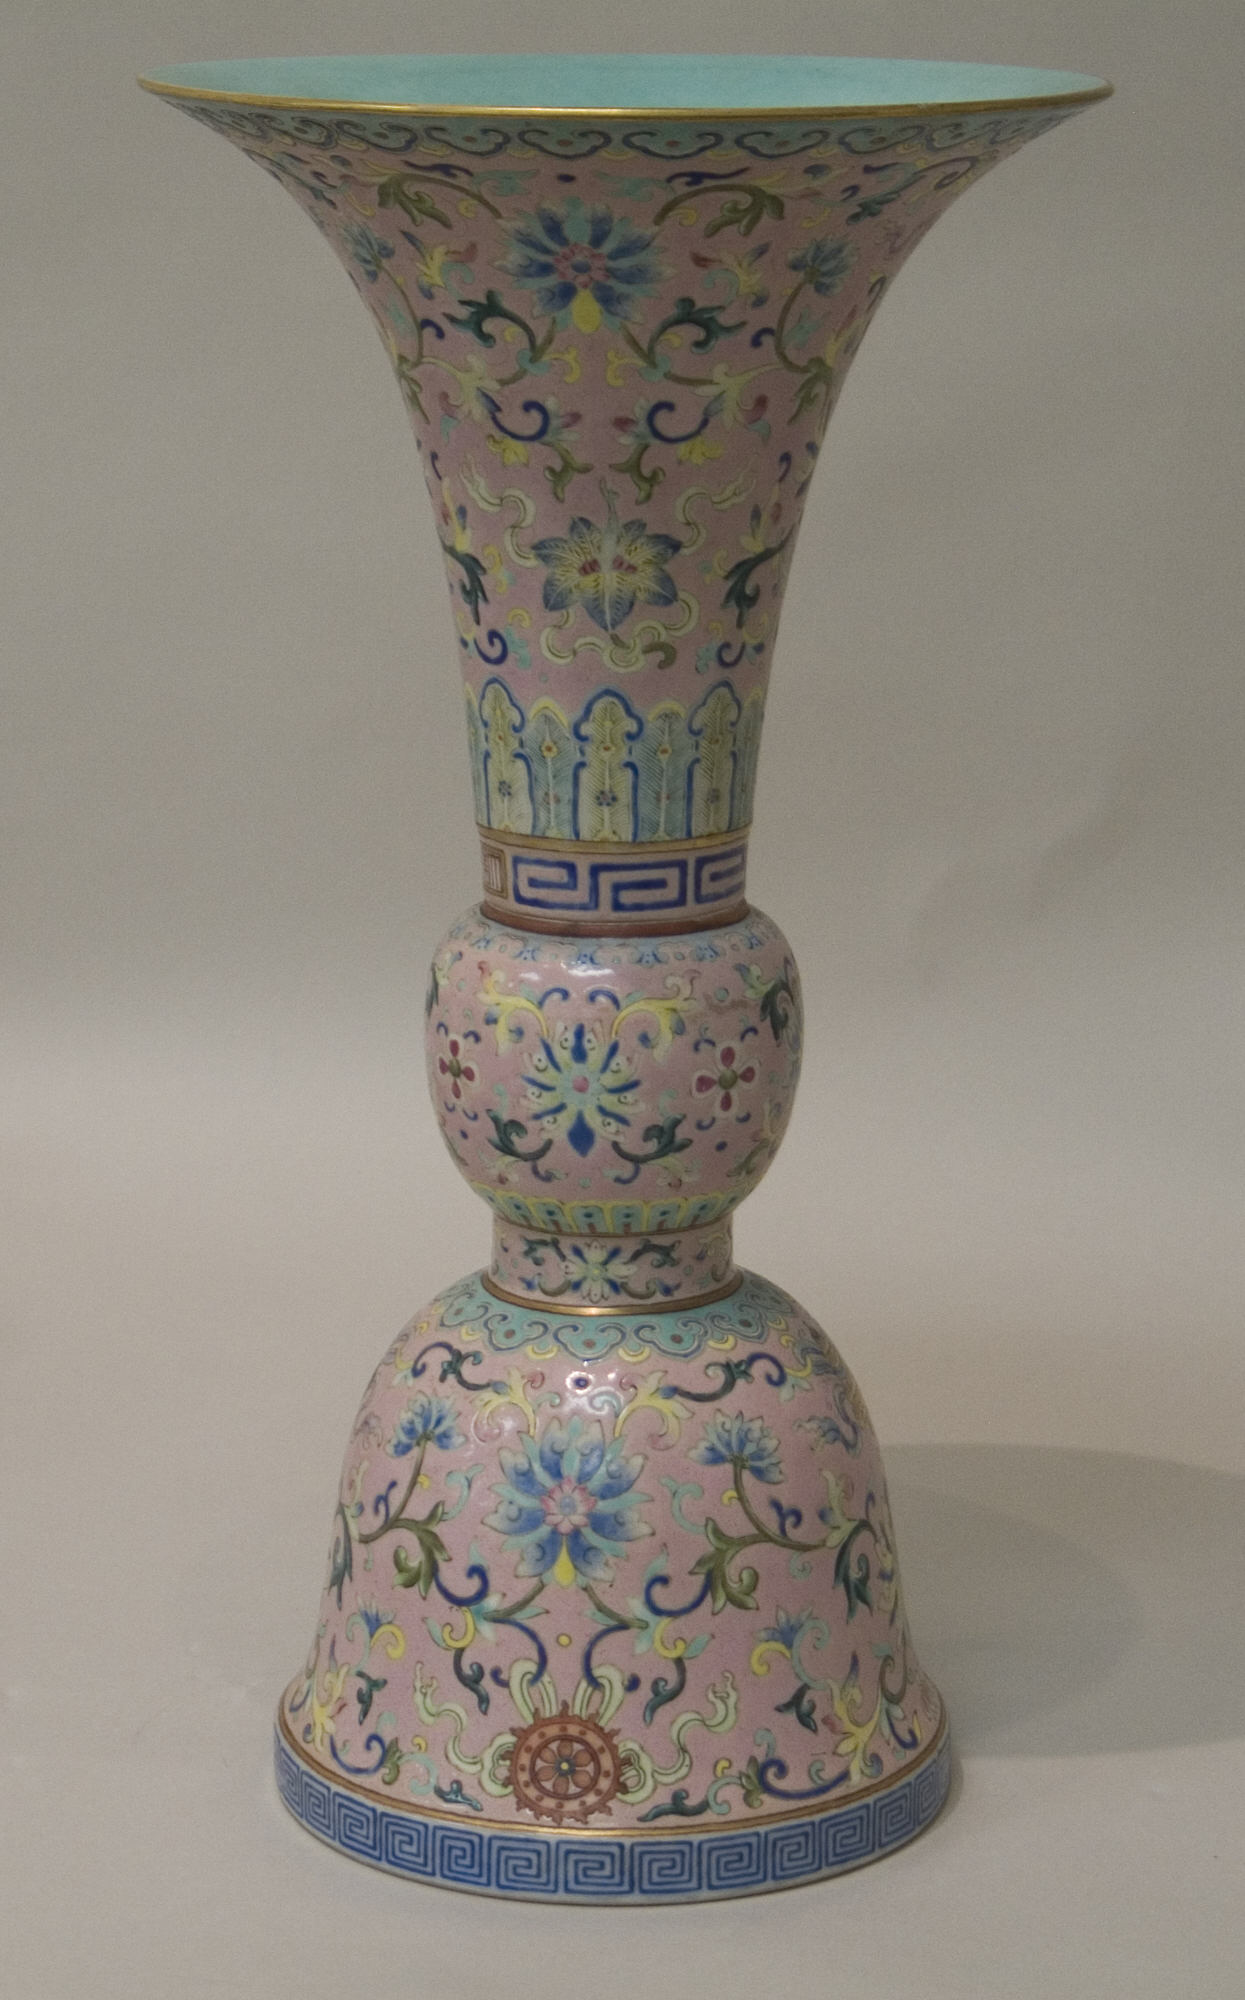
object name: altar set piece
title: Vase from a five-piece altar set (wugong)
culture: chinese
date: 1834-1866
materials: enamel, porcelain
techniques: overglaze, painting, polychrome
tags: flowers